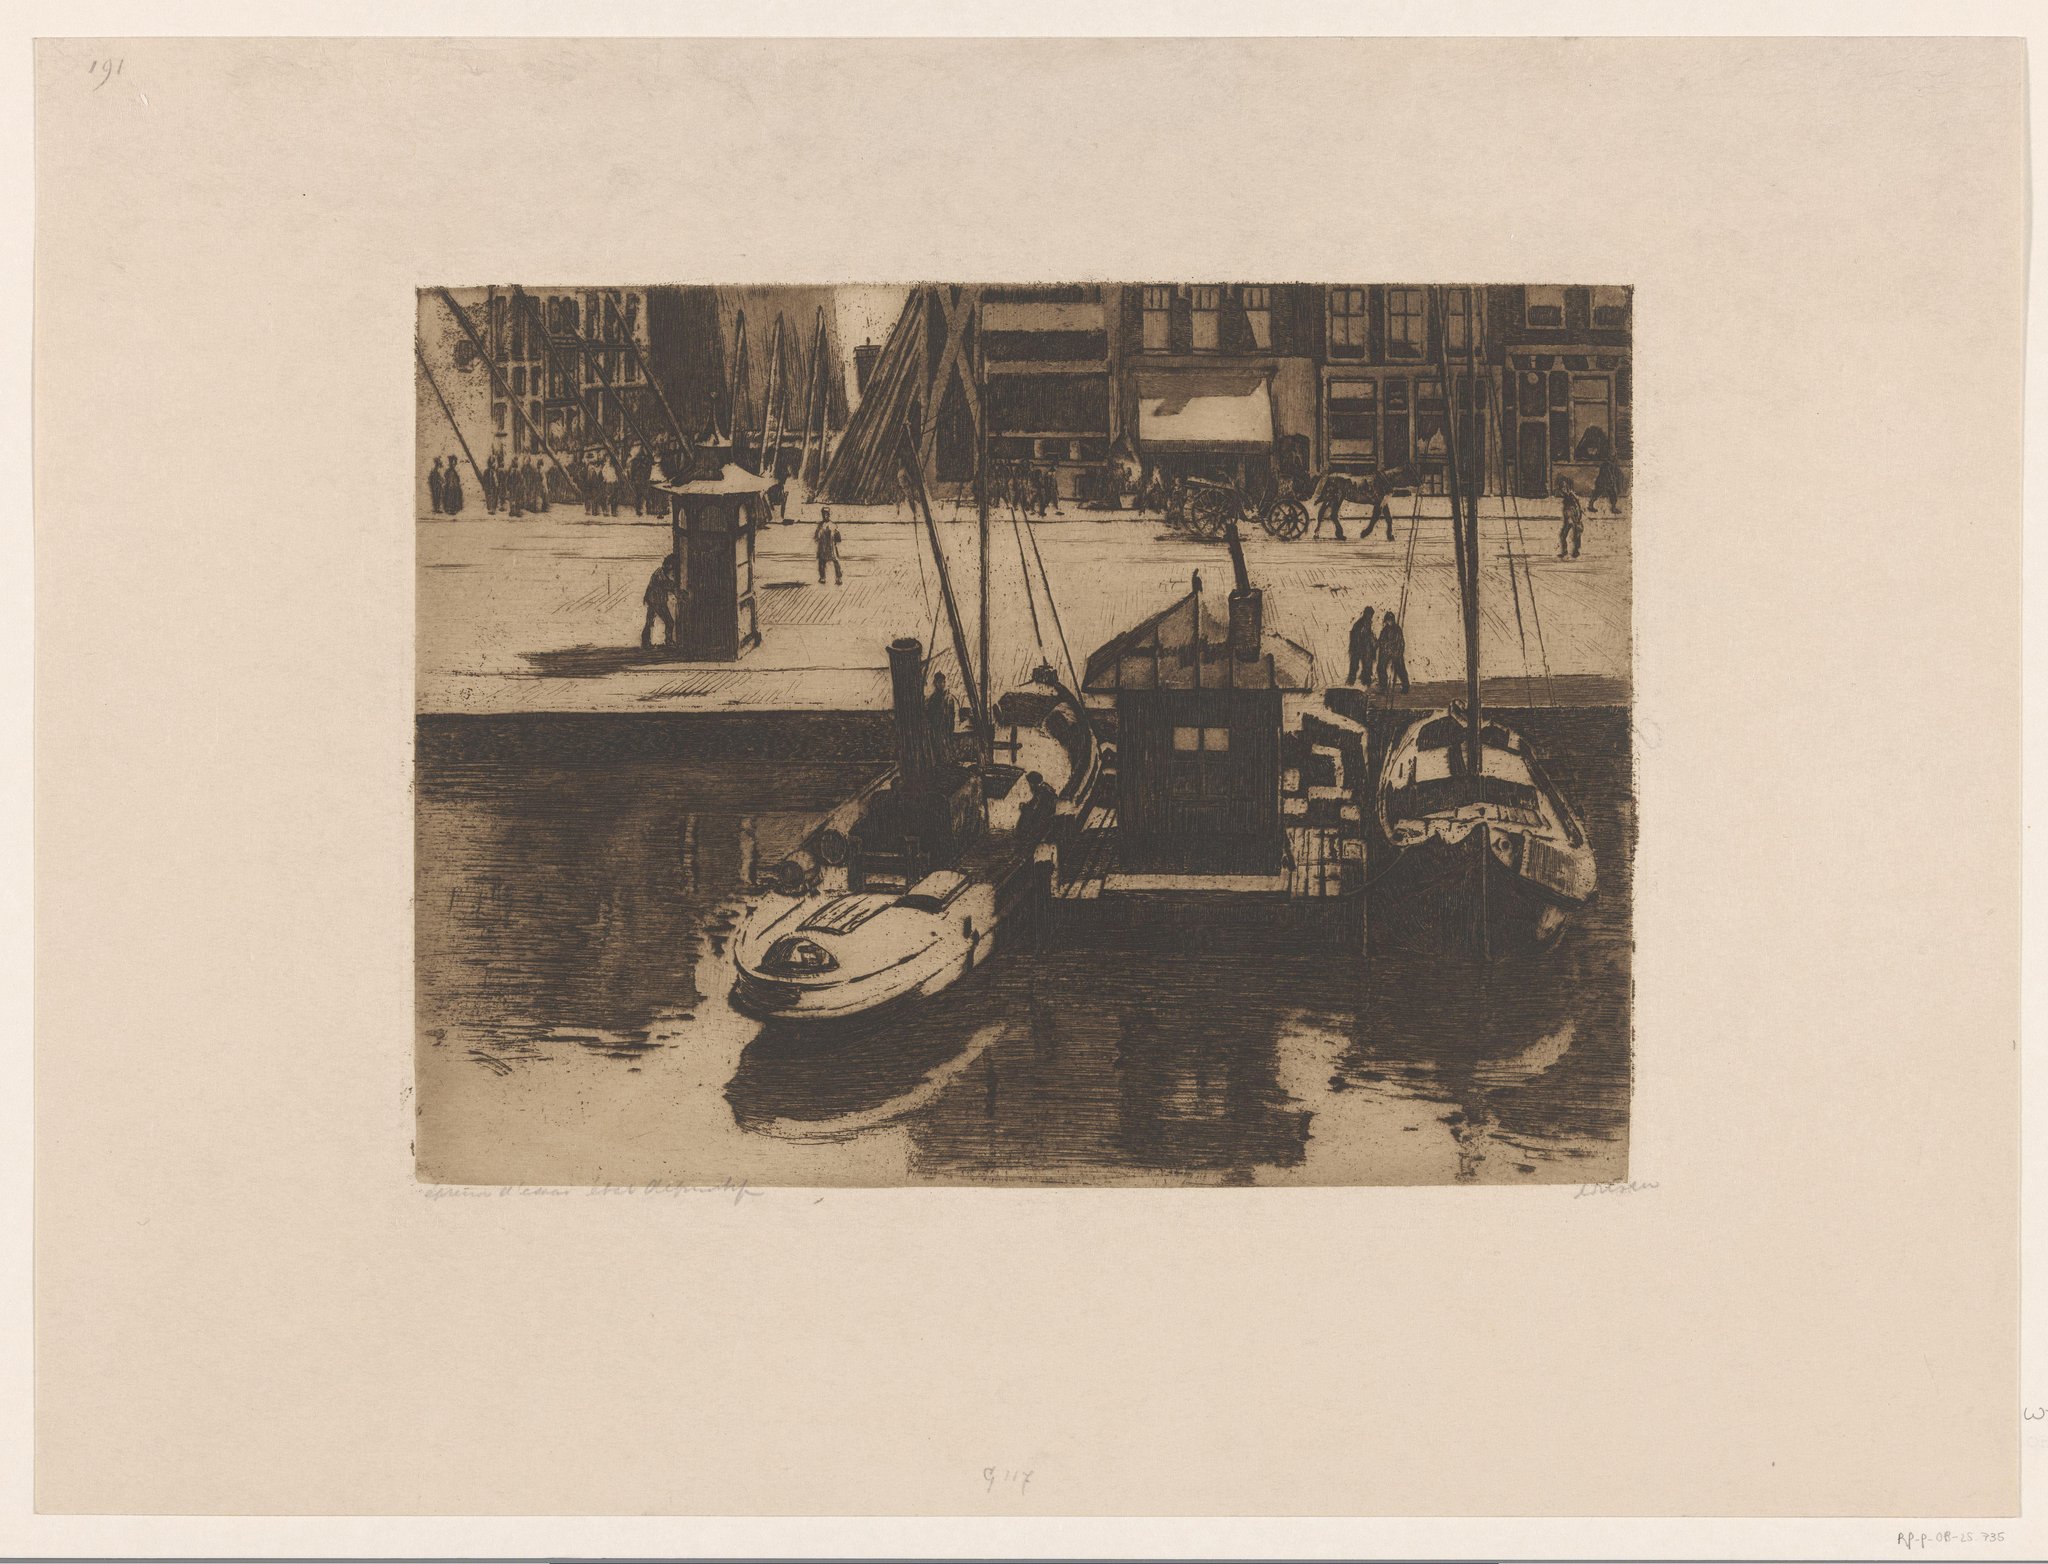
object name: print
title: Aangemeerde boten aan het Damrak in Amsterdam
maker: willem witsen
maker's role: draughtsman, painter, print maker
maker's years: 1860-1923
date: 1906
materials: paper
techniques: aquatint, etching, intaglio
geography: amsterdam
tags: city dwellers, canals, waters (in city), boat propelled by man or animal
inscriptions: inscription: ‘épreuve d'essai état definitif’, collector's mark: Lugt 2228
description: Aanlegsteiger met boten aan het Damrak. Daarachter de ingang van de Karnemelksteeg.